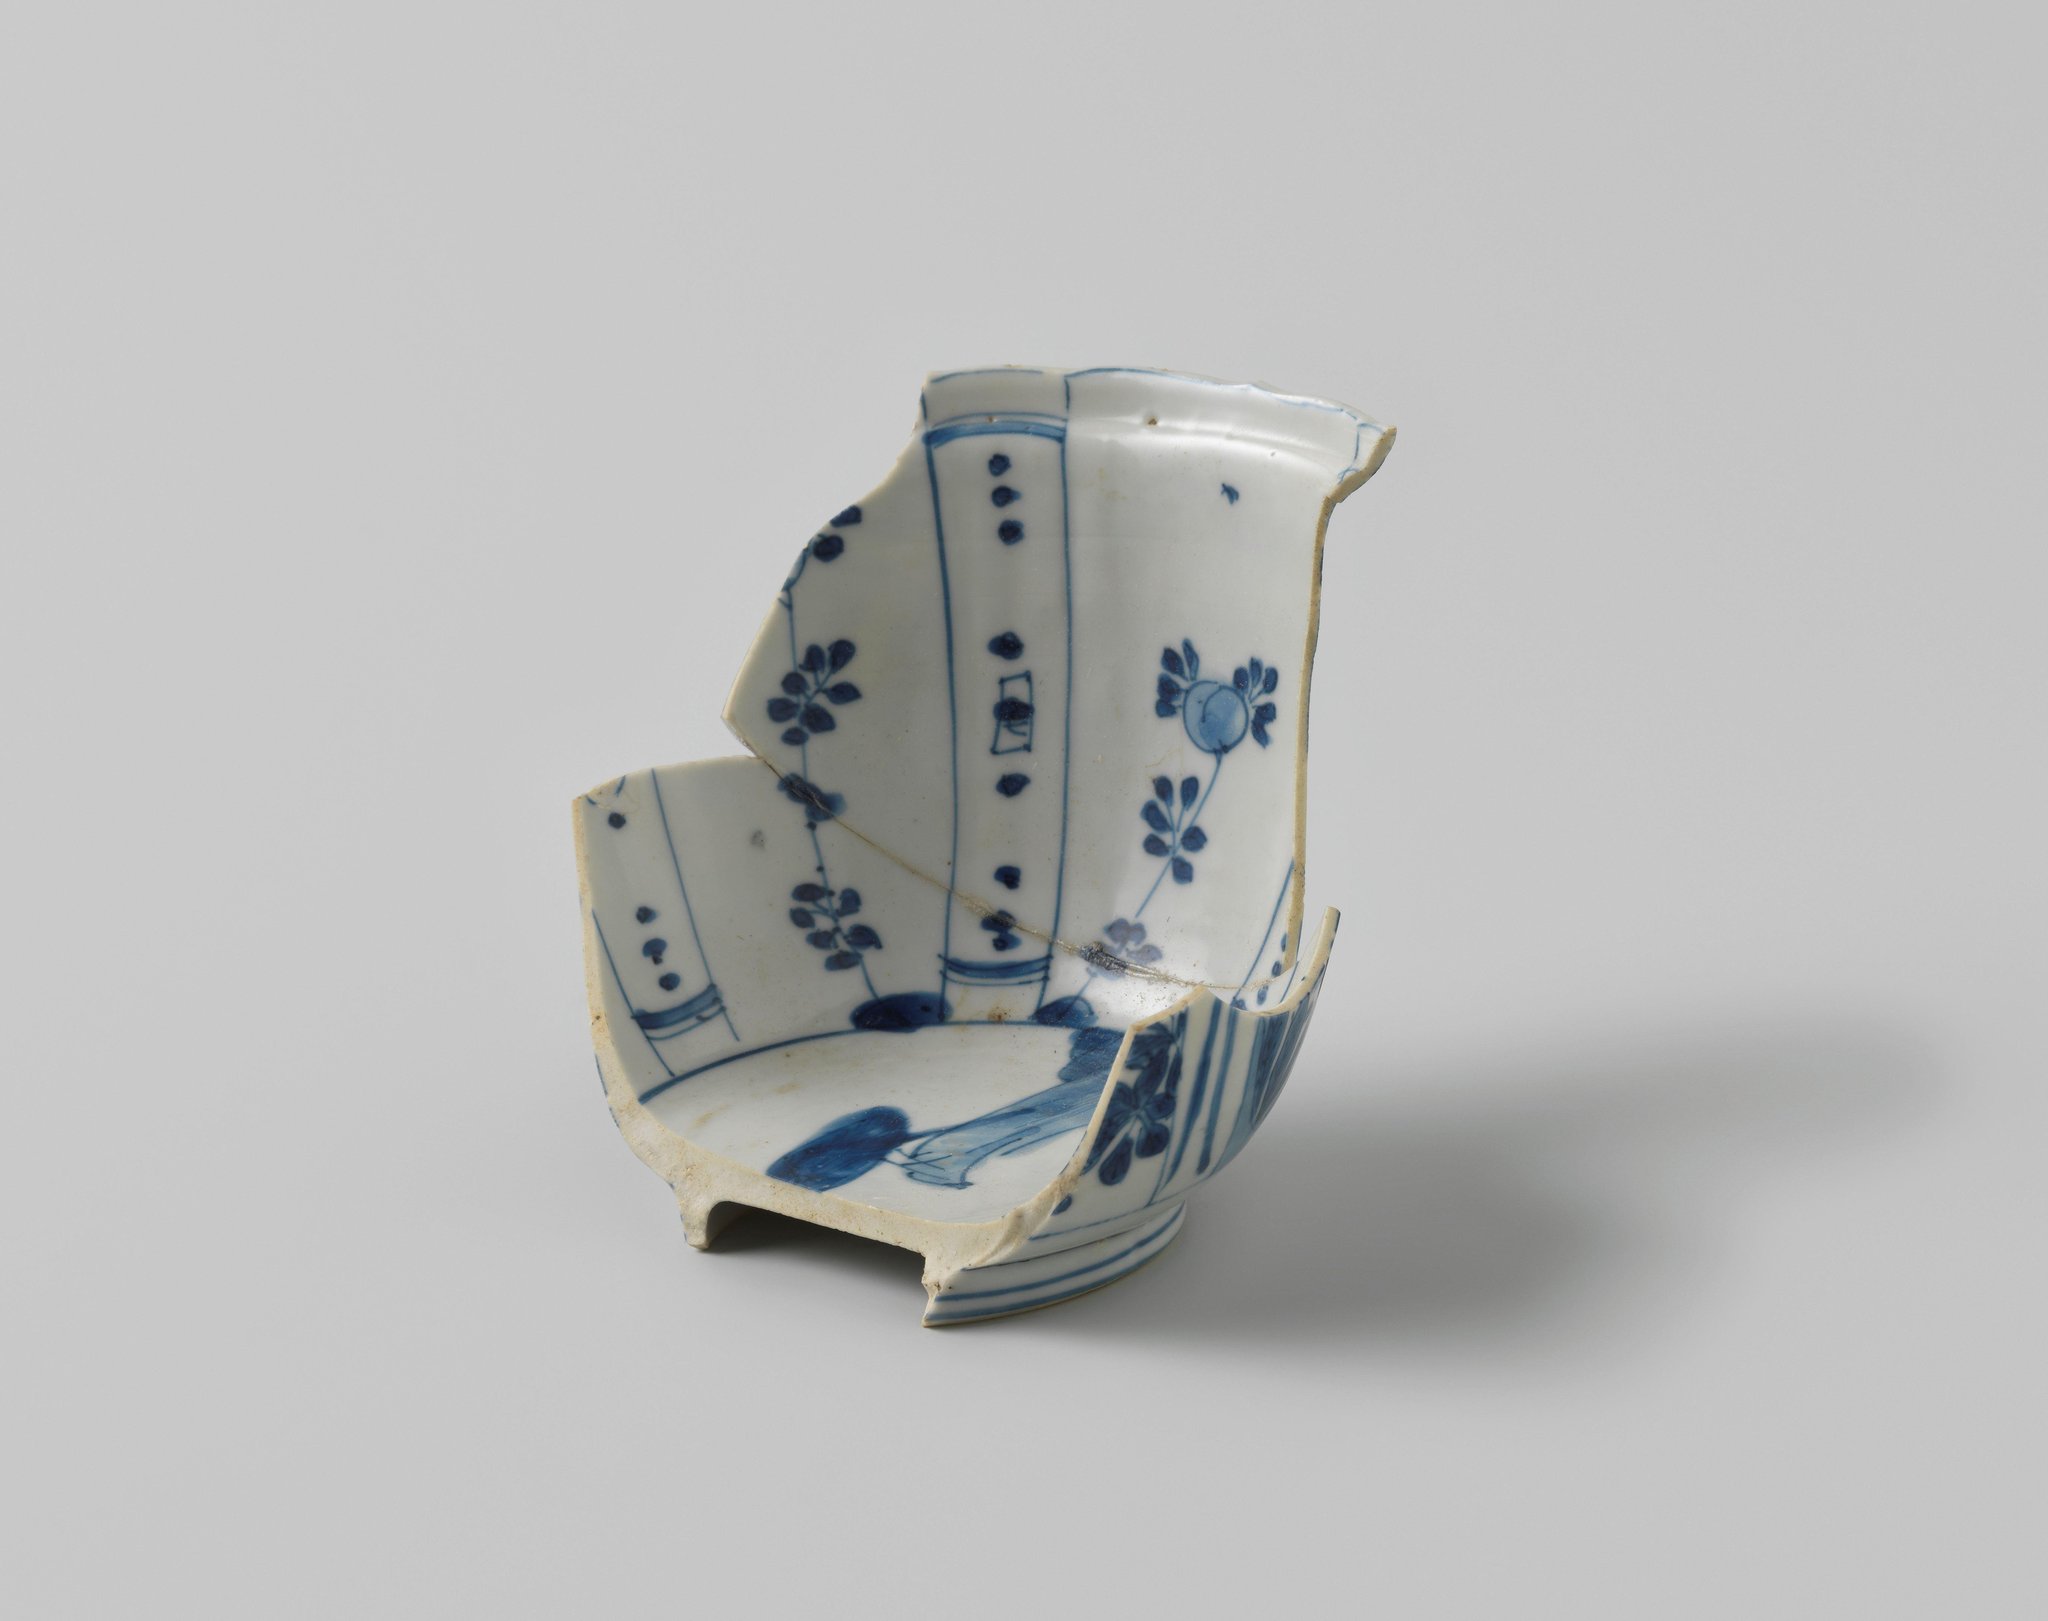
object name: bowl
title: Fragment kraaikop uit V.O.C.-schip de 'Witte Leeuw'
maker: Anonymous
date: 1613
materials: bone china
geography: jingdezhen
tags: verenigde oostindische compagnie, sint-helena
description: Fragment kraaikop uit V.O.C.-schip de 'Witte Leeuw', 50% aanwezig.